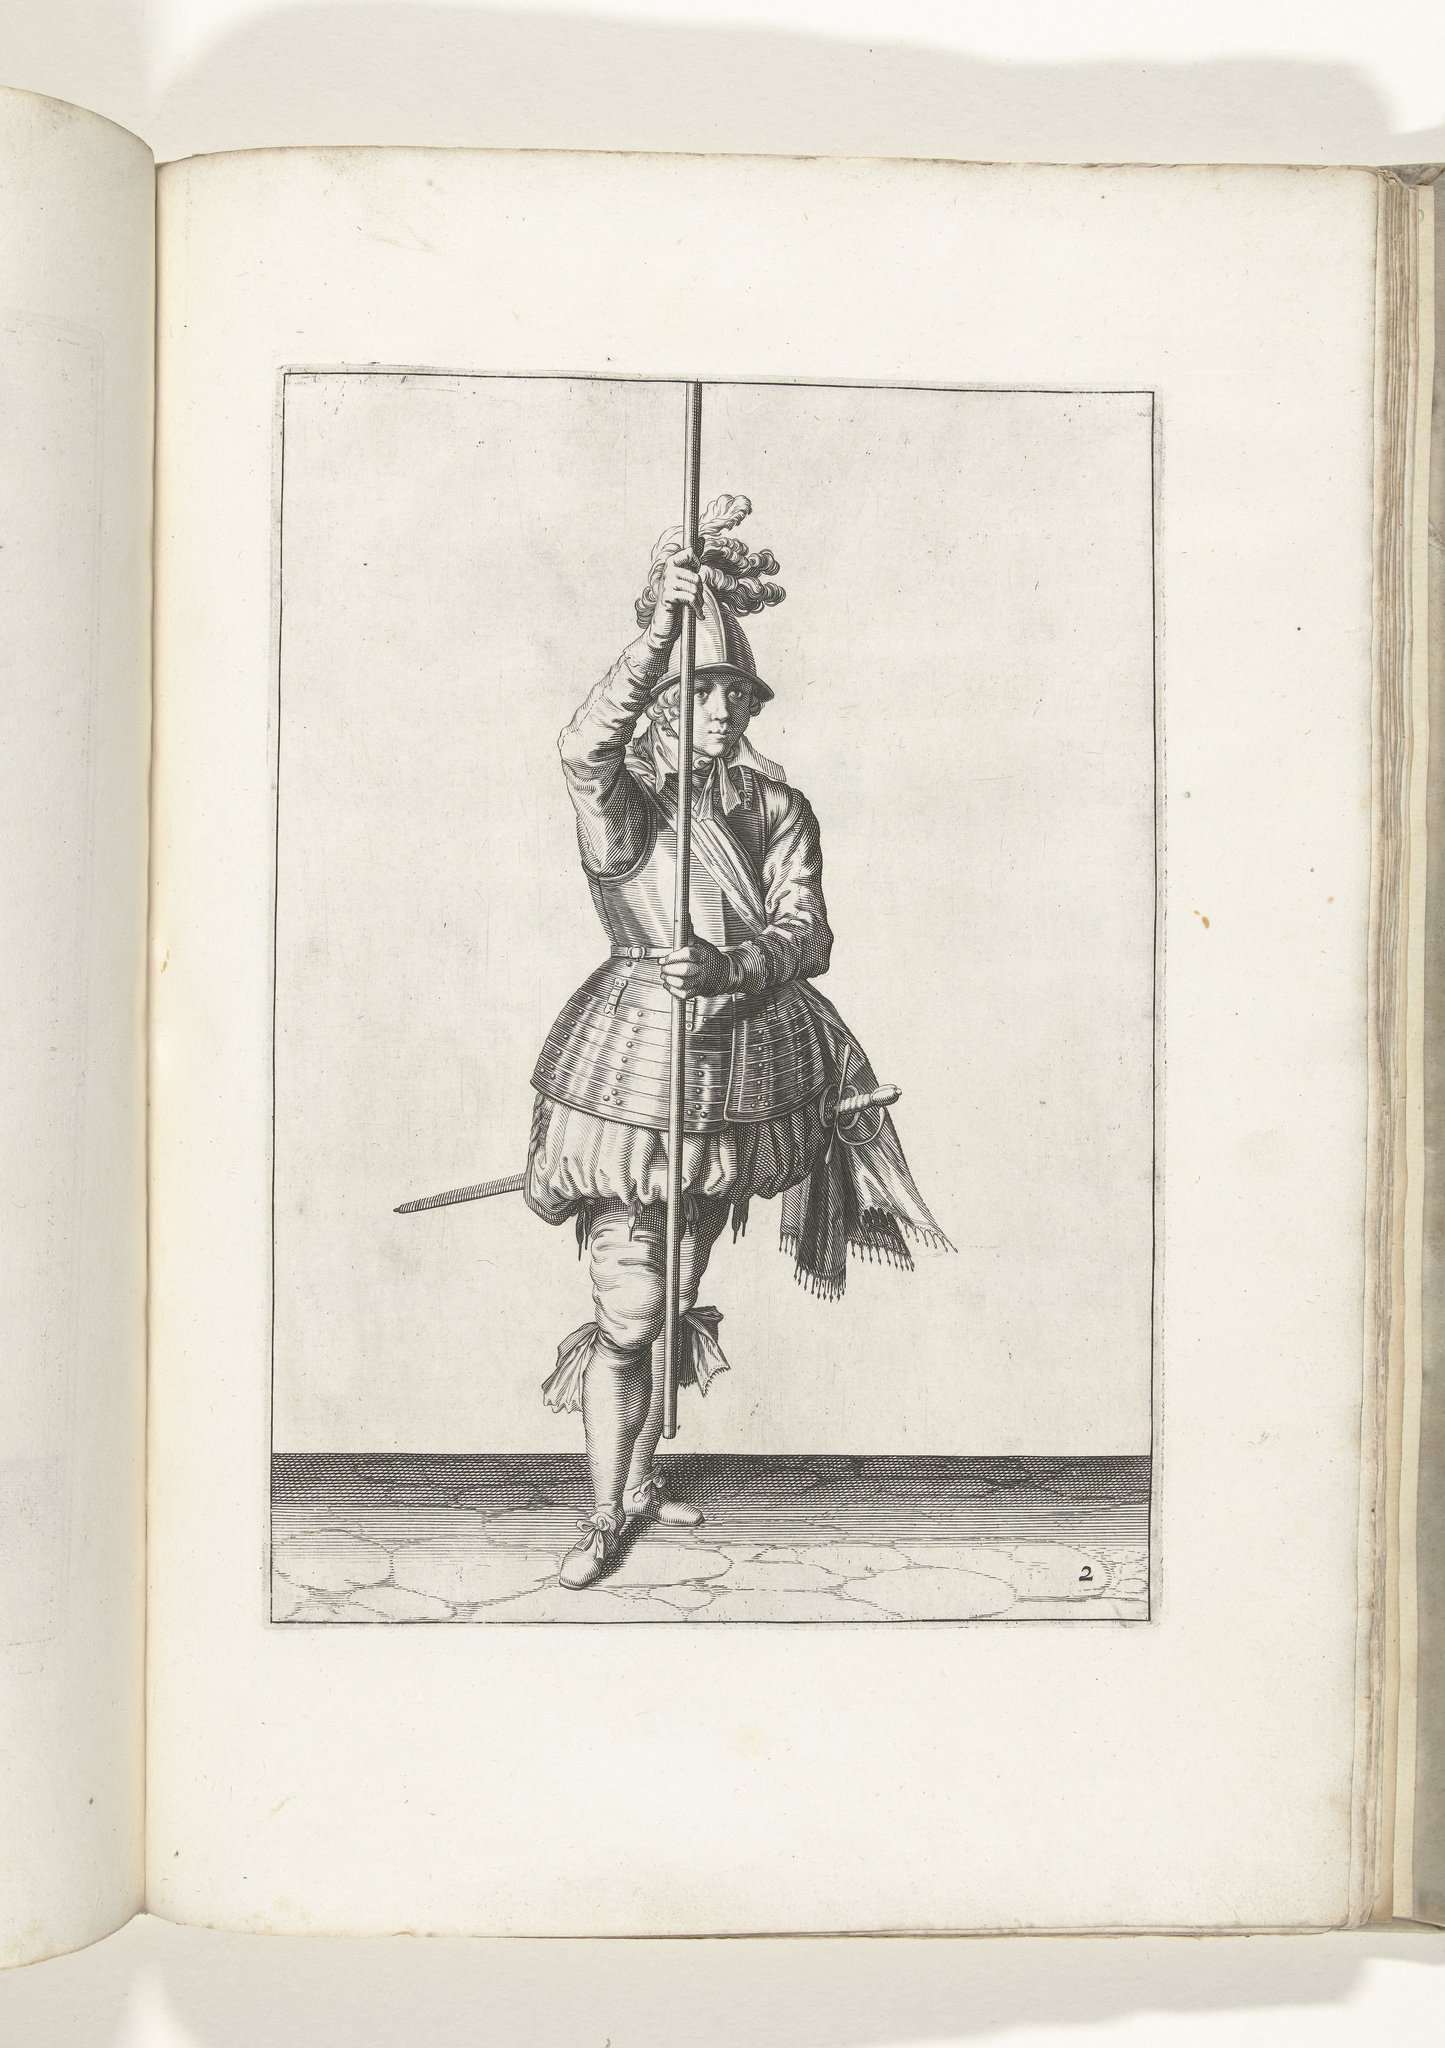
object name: print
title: Soldaat, van voren gezien, die zijn spies met beide handen rechtop voor zich iets boven de grond vasthoudt (nr. 2), ca. 1600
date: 1597-1607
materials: paper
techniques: engraving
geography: northern netherlands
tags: the hague, maurice (prince of orange), handling of weapons ~ military training, weapons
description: Een soldaat, ten voeten uit, die een spies (lans) met beide handen rechtop voor zich iets boven de grond vasthoudt (nr. 2), ca. 1600. Dit is de eerste handeling voor het rechtop opheffen van de spies. Plaat 2 in de instructies voor het hanteren van de spies: Corte onderwysinghe op de figuerliicke afbeeldinghe, belanghende t'recht ghebruyck, van al t'ghene een Soldaet int handelen vande Spies noodich is. Onderdeel van de illustraties in: J. de Gheyn, Wapenhandelinghe van Roers Musquetten ende spiessen, 's-Gravenhage, 1607. Krijgswezen rond 1600.